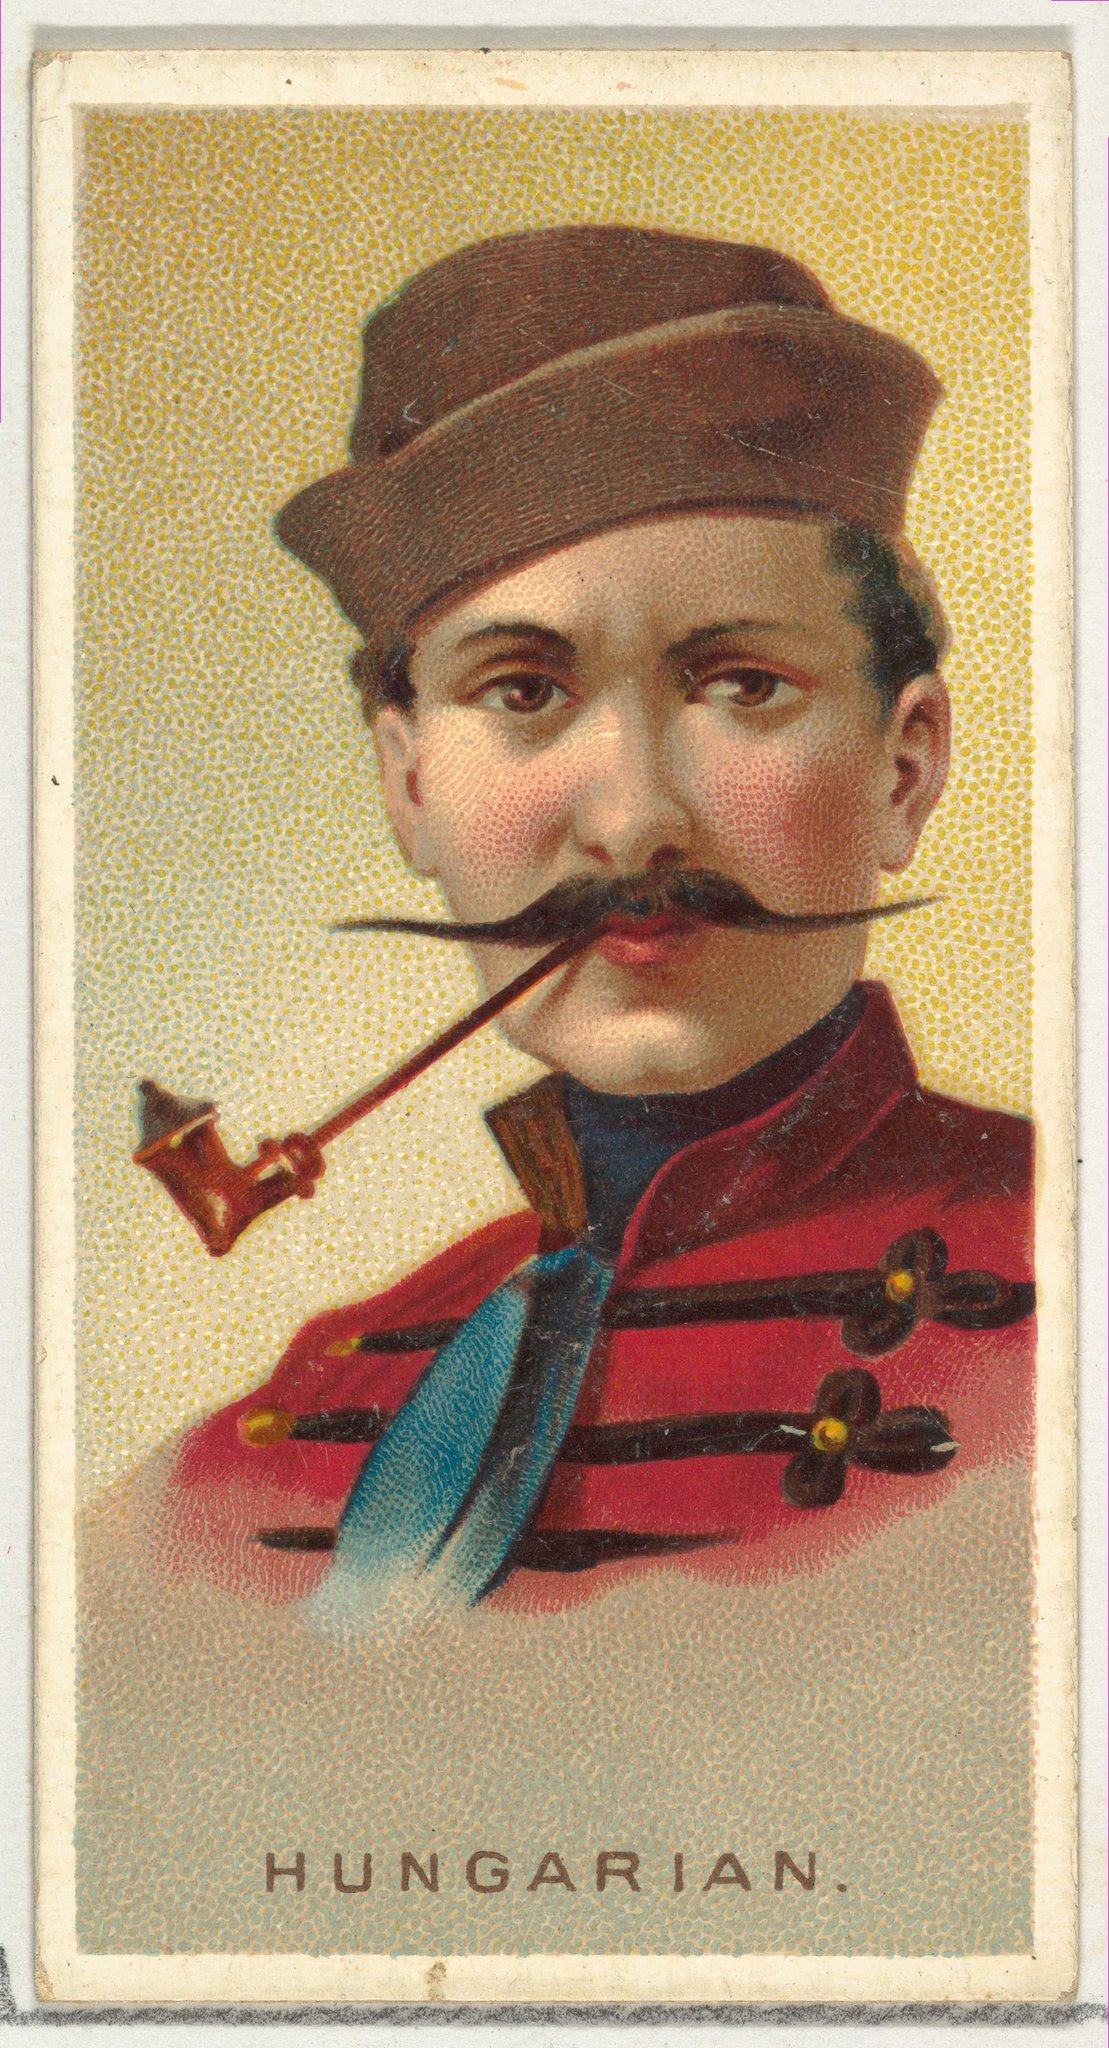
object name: print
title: Hungarian, from World's Smokers series (N33) for Allen & Ginter Cigarettes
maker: allen & ginter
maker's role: publisher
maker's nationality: american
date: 1888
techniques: color lithograph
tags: men,smoking